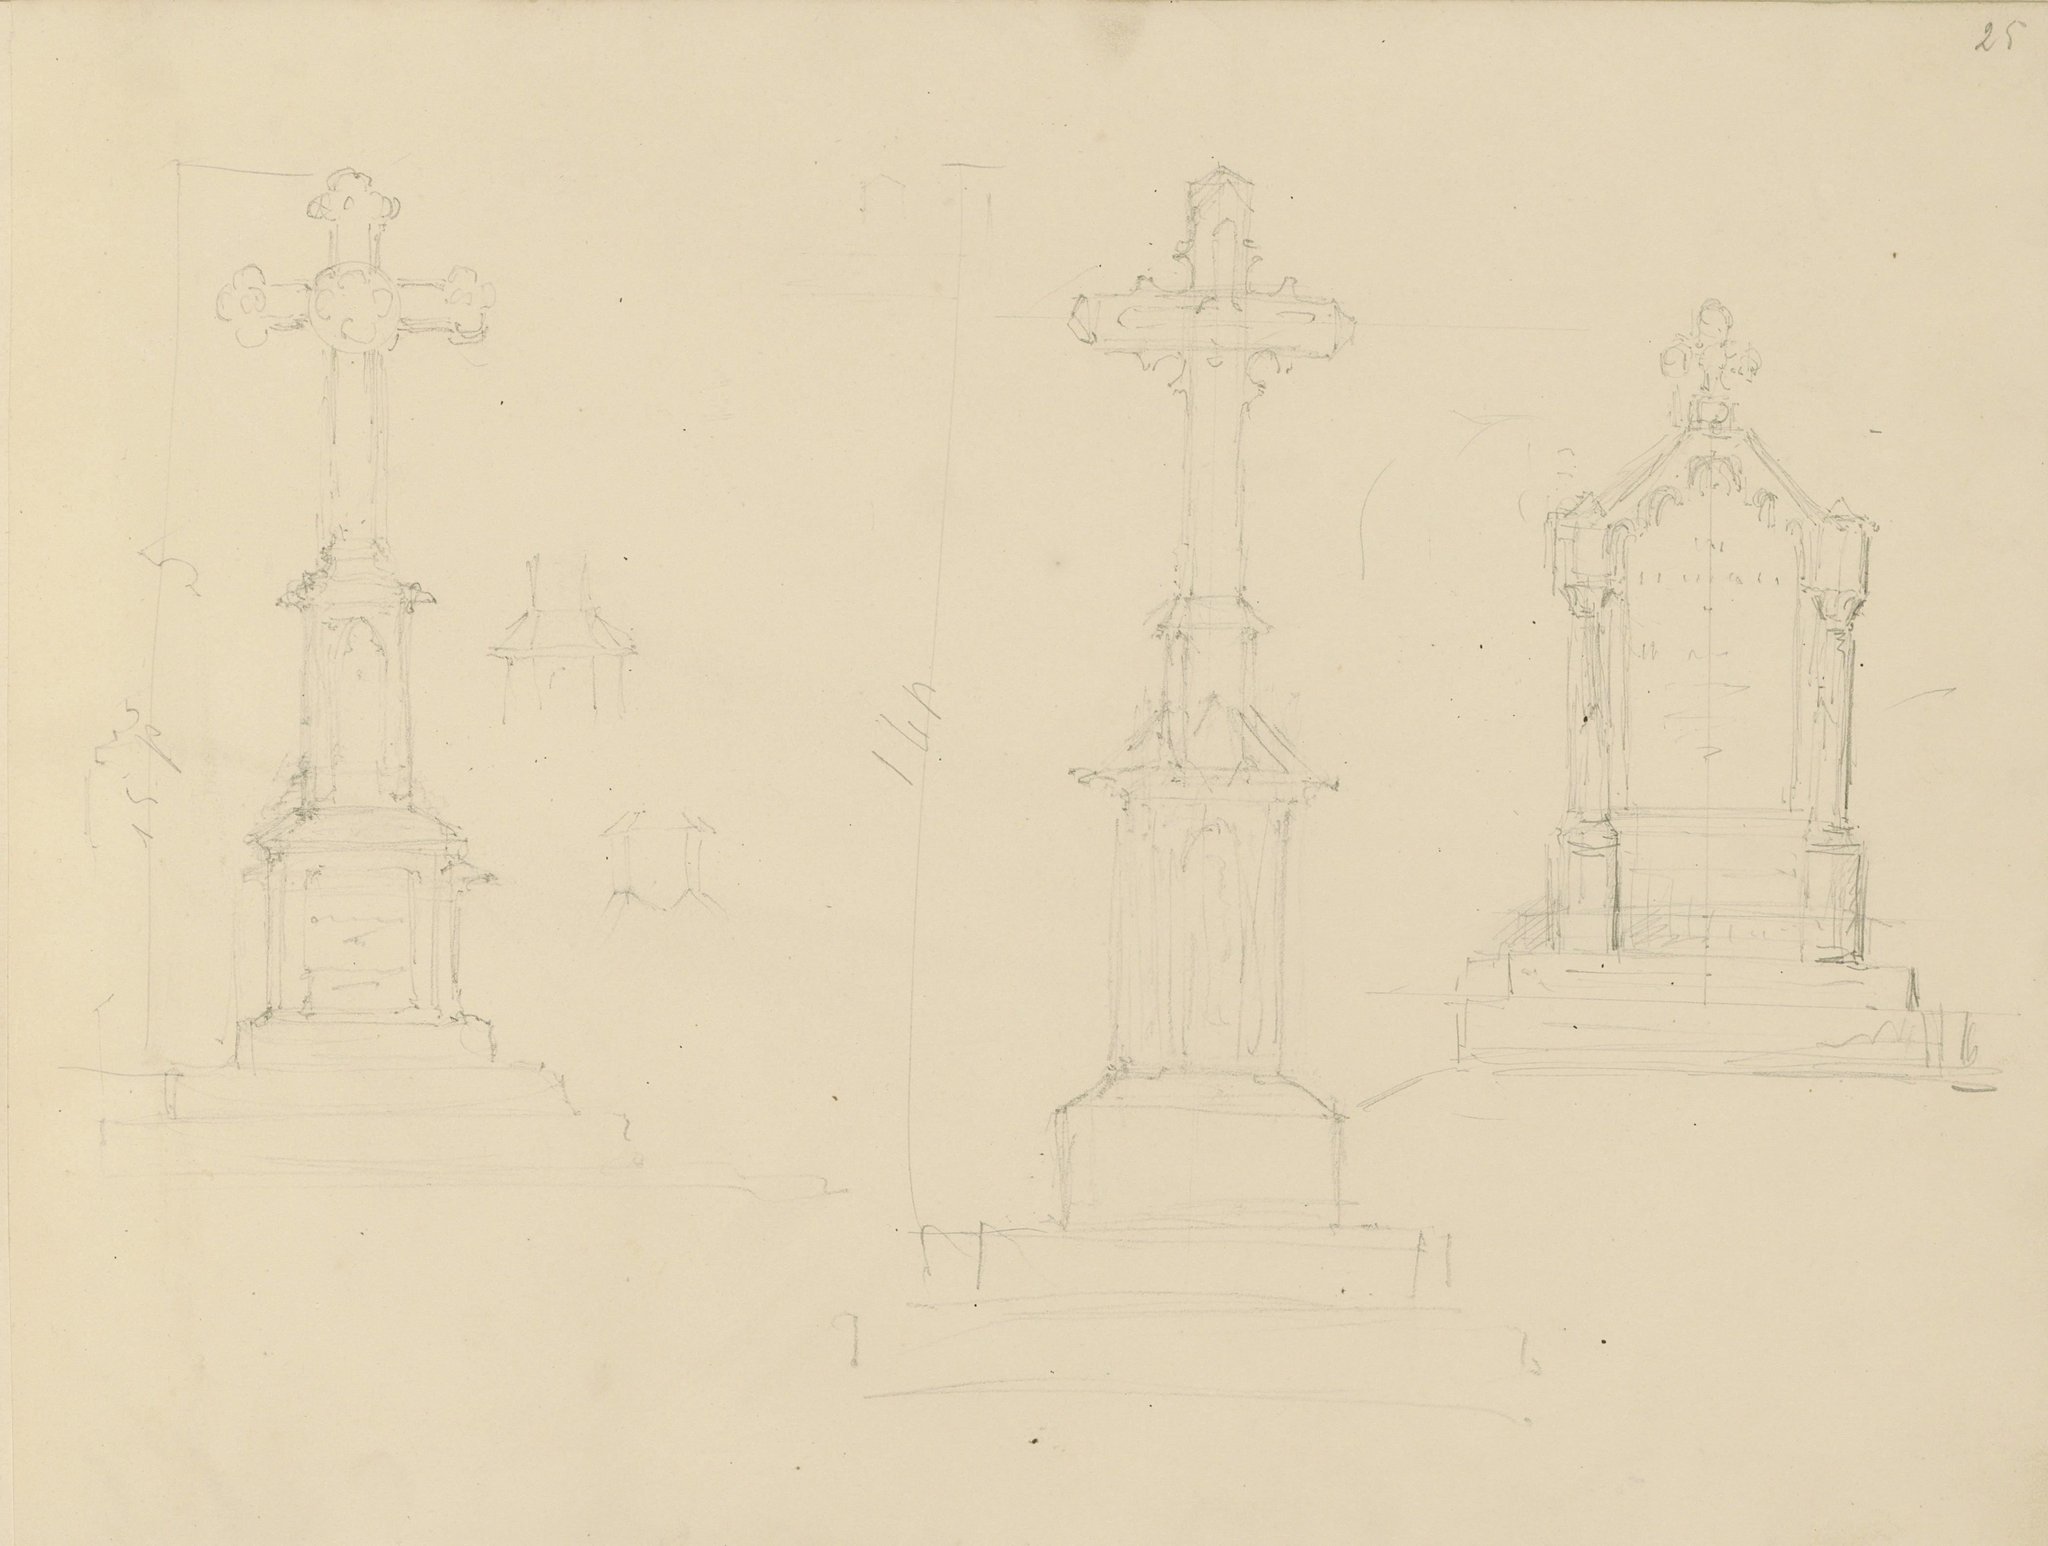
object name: sketchbook leaf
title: Grafmonumenten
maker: pierre joseph hubert cuypers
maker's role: draughtsman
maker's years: 1827-1921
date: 1850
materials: paper, pencil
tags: monument, statue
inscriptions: annotation: ‘[...]’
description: Blad 25 recto uit een schetsboek met 37 bladen.